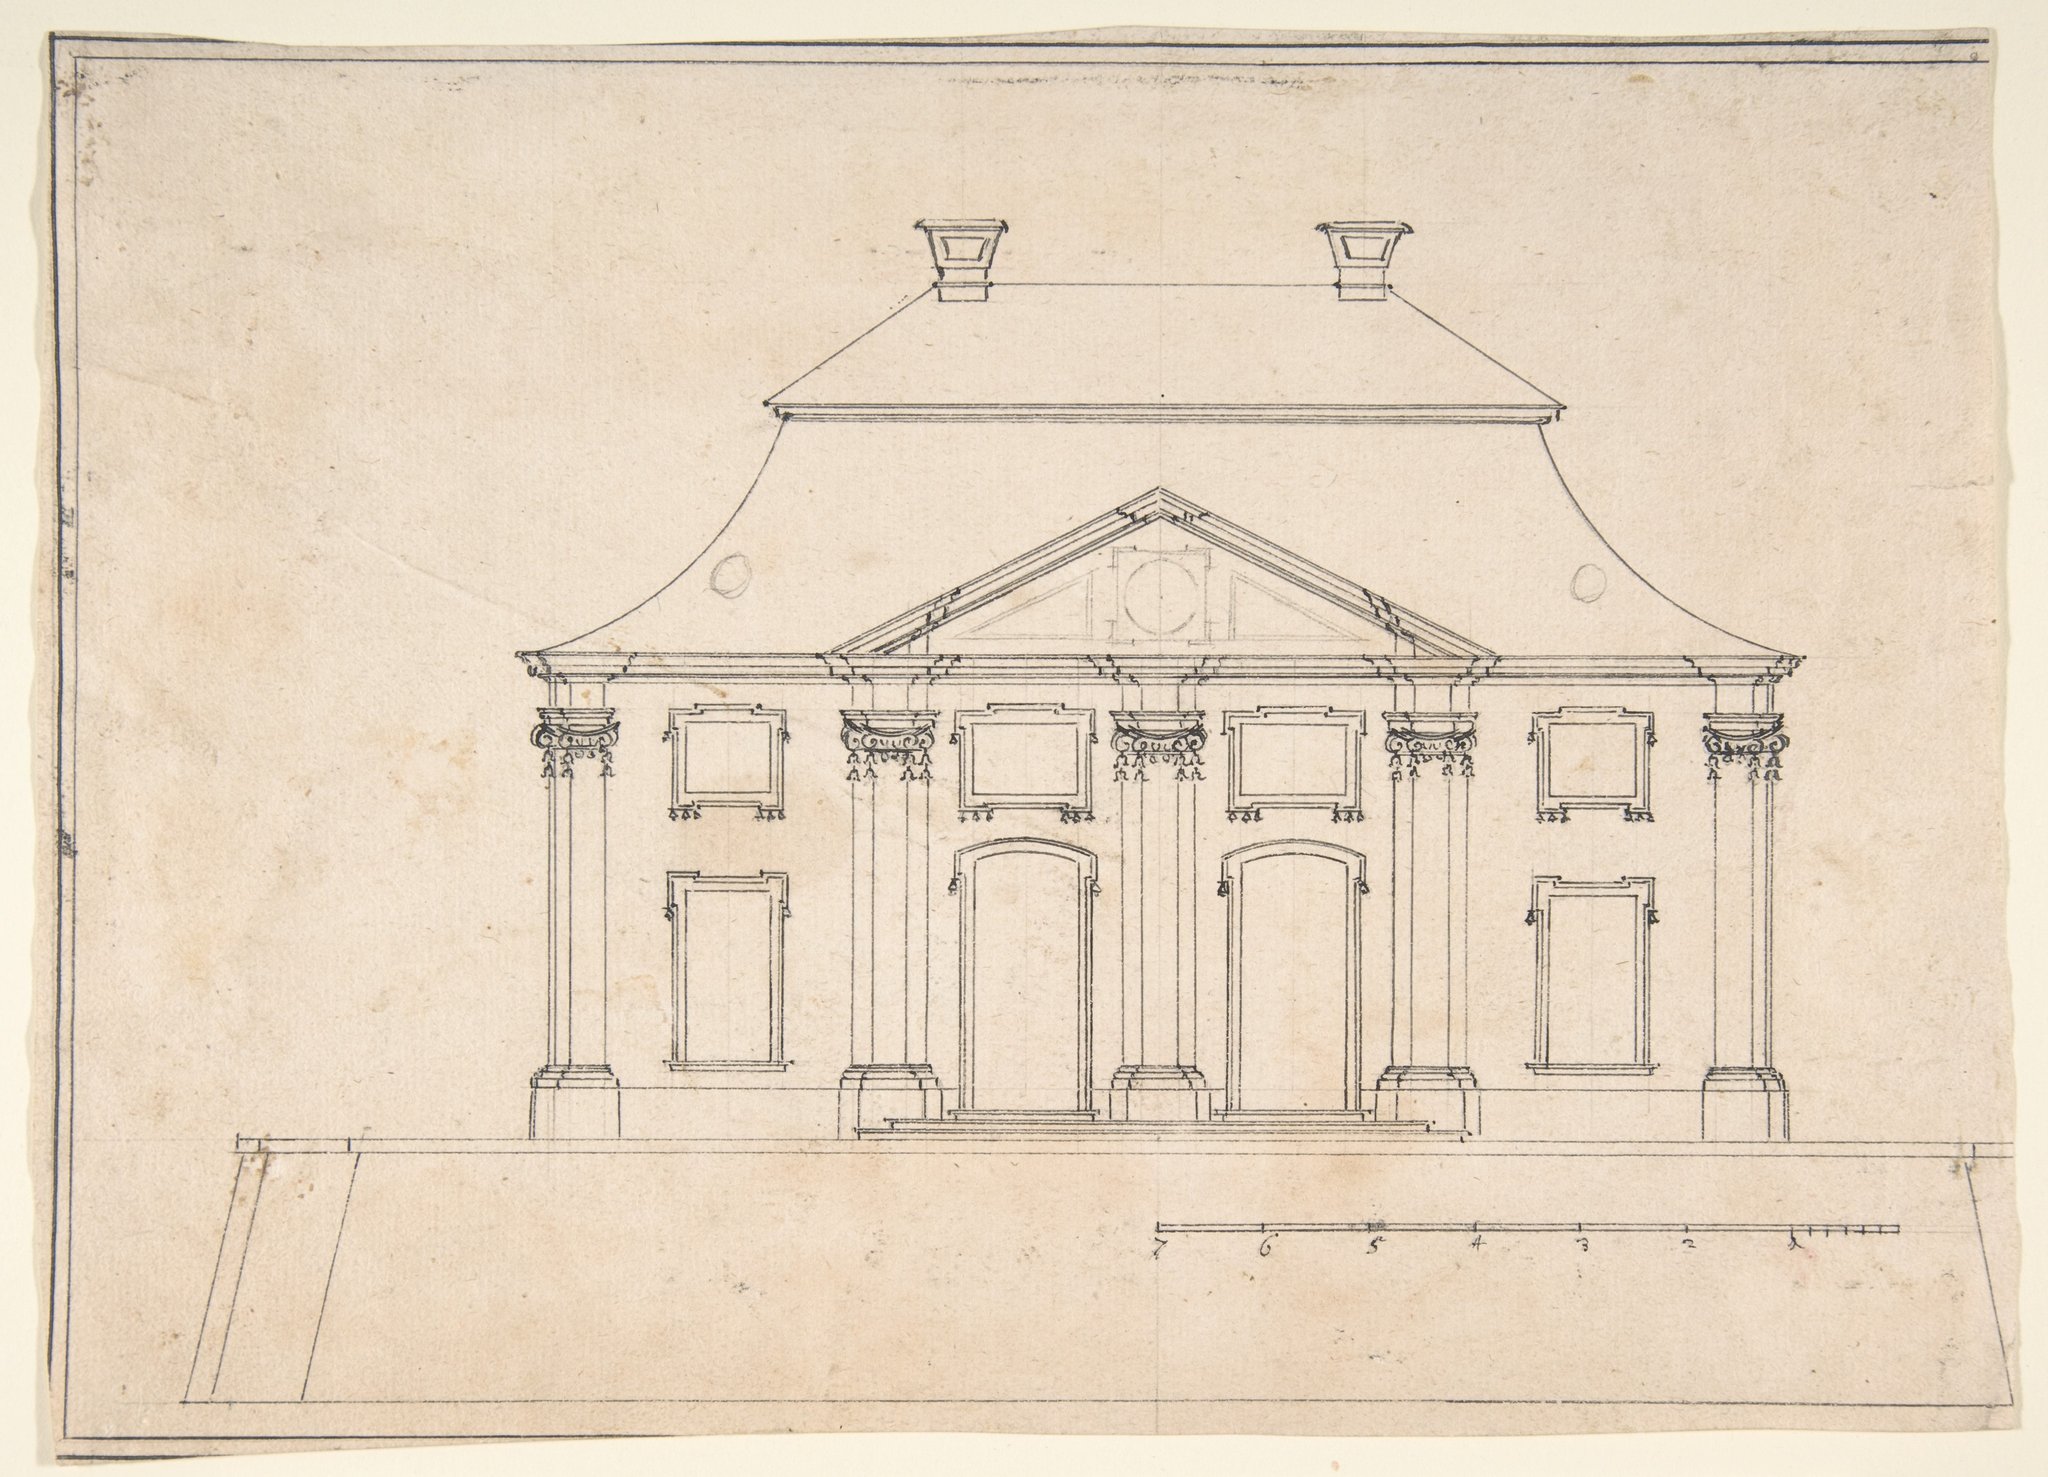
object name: drawing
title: Architectural Design for Exterior of City House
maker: anonymous, french, 19th century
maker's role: artist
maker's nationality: french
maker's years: 1800-1900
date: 1801-1900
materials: graphite, ink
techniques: pen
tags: architecture,buildings